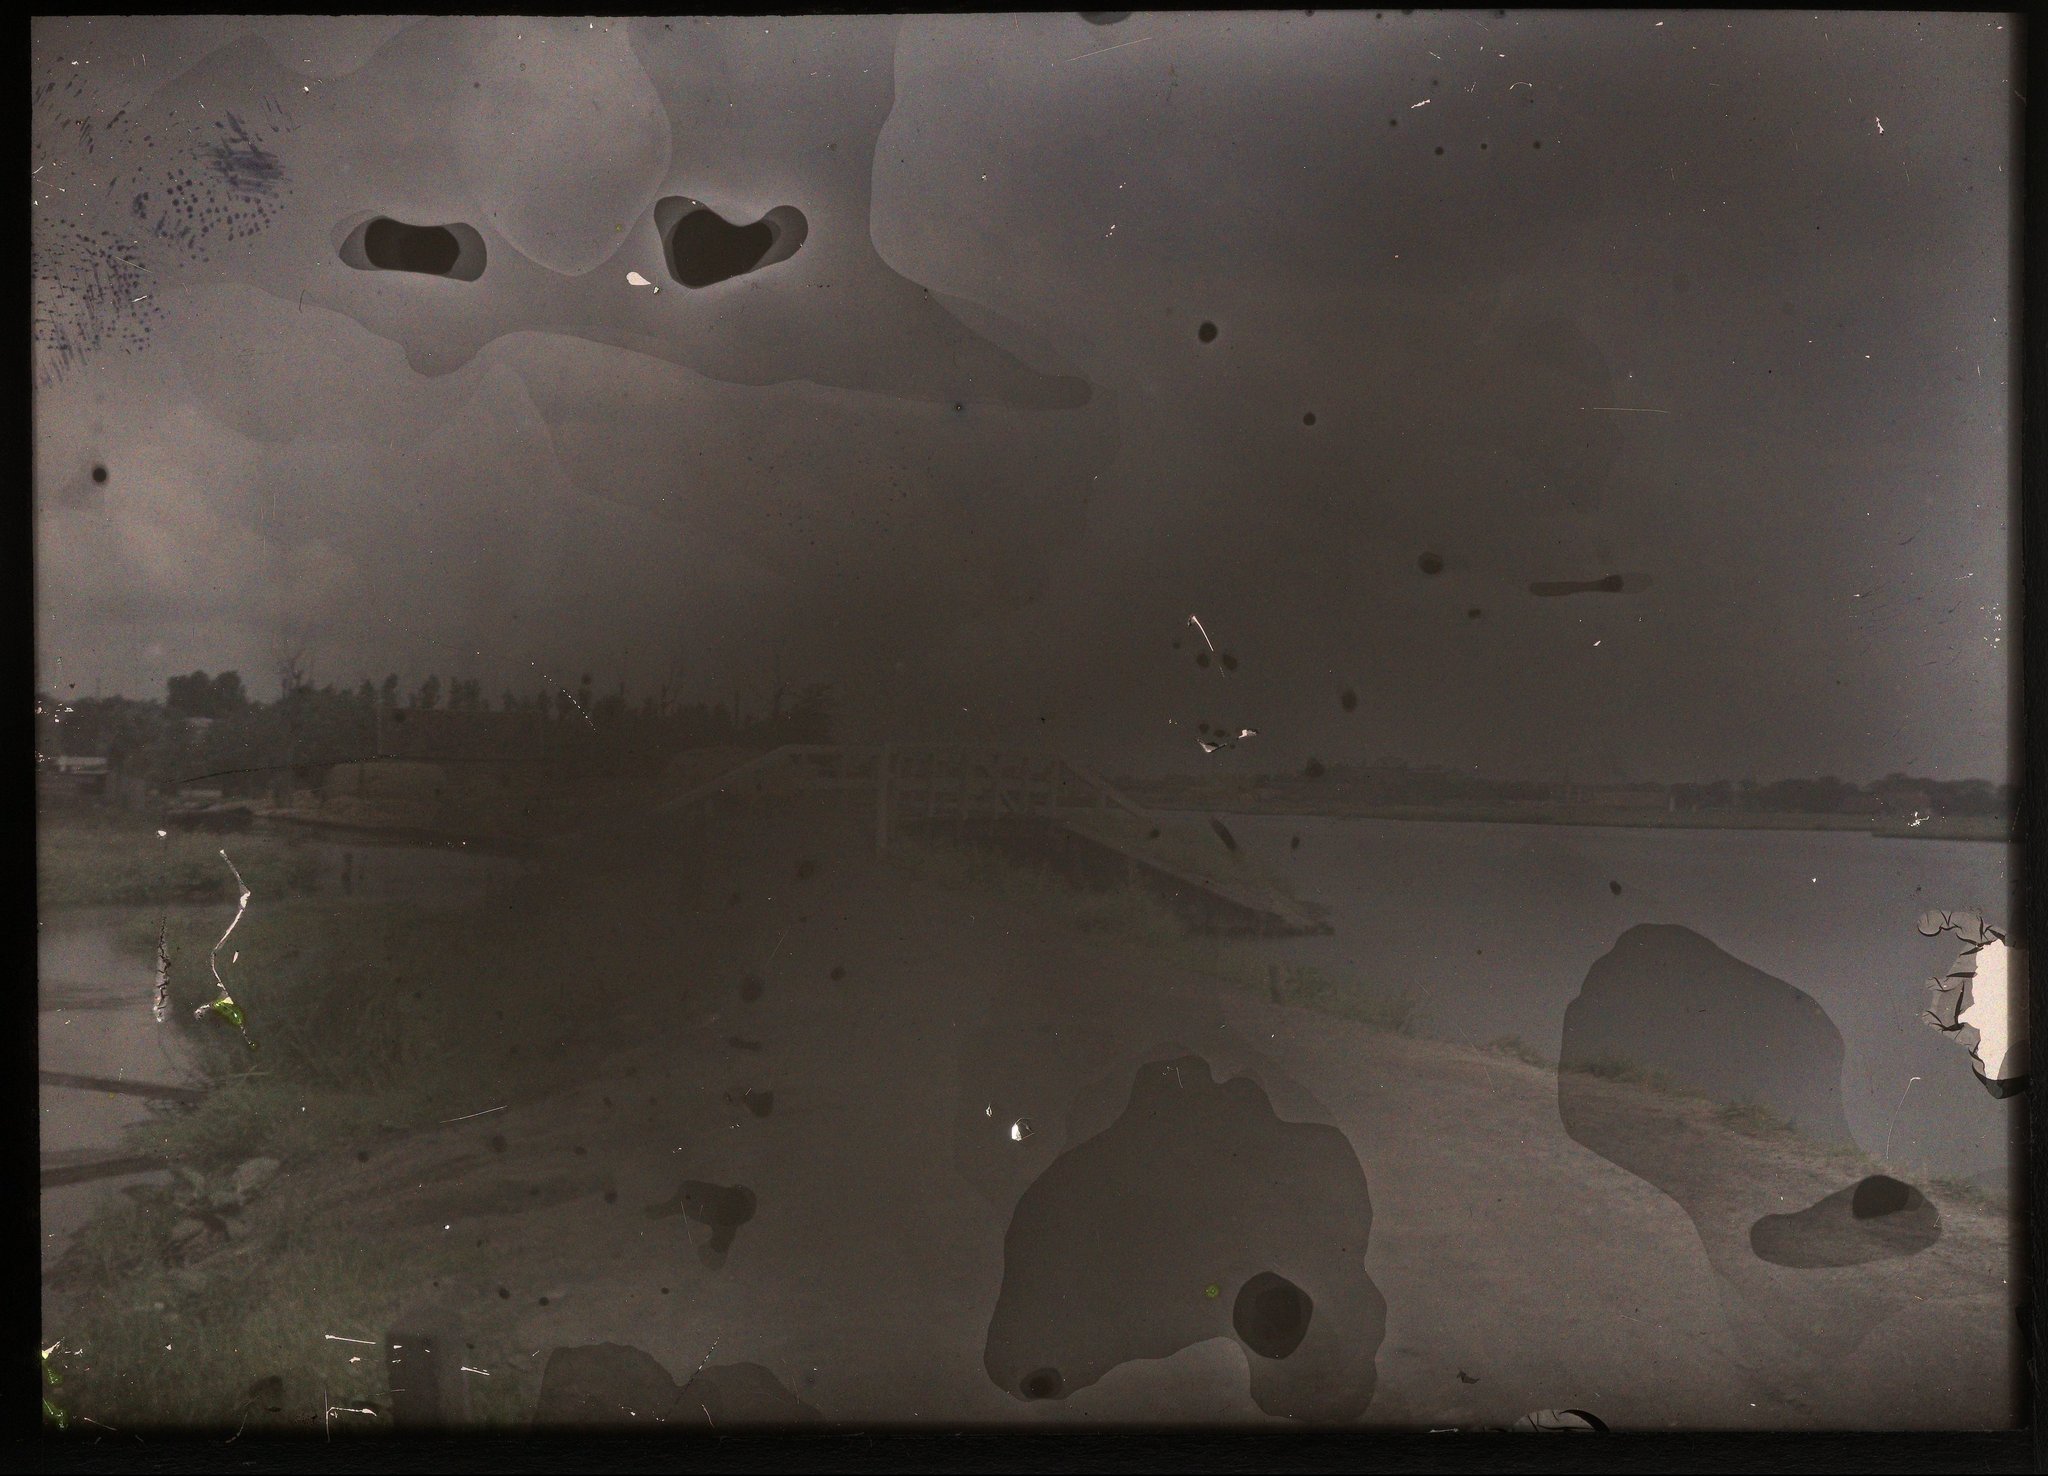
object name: photograph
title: Gezicht op een brug bij een vaart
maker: adolphe burdet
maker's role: fotograaf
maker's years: 1860-1940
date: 1907-1930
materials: glass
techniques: autochrome process, slide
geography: netherlands